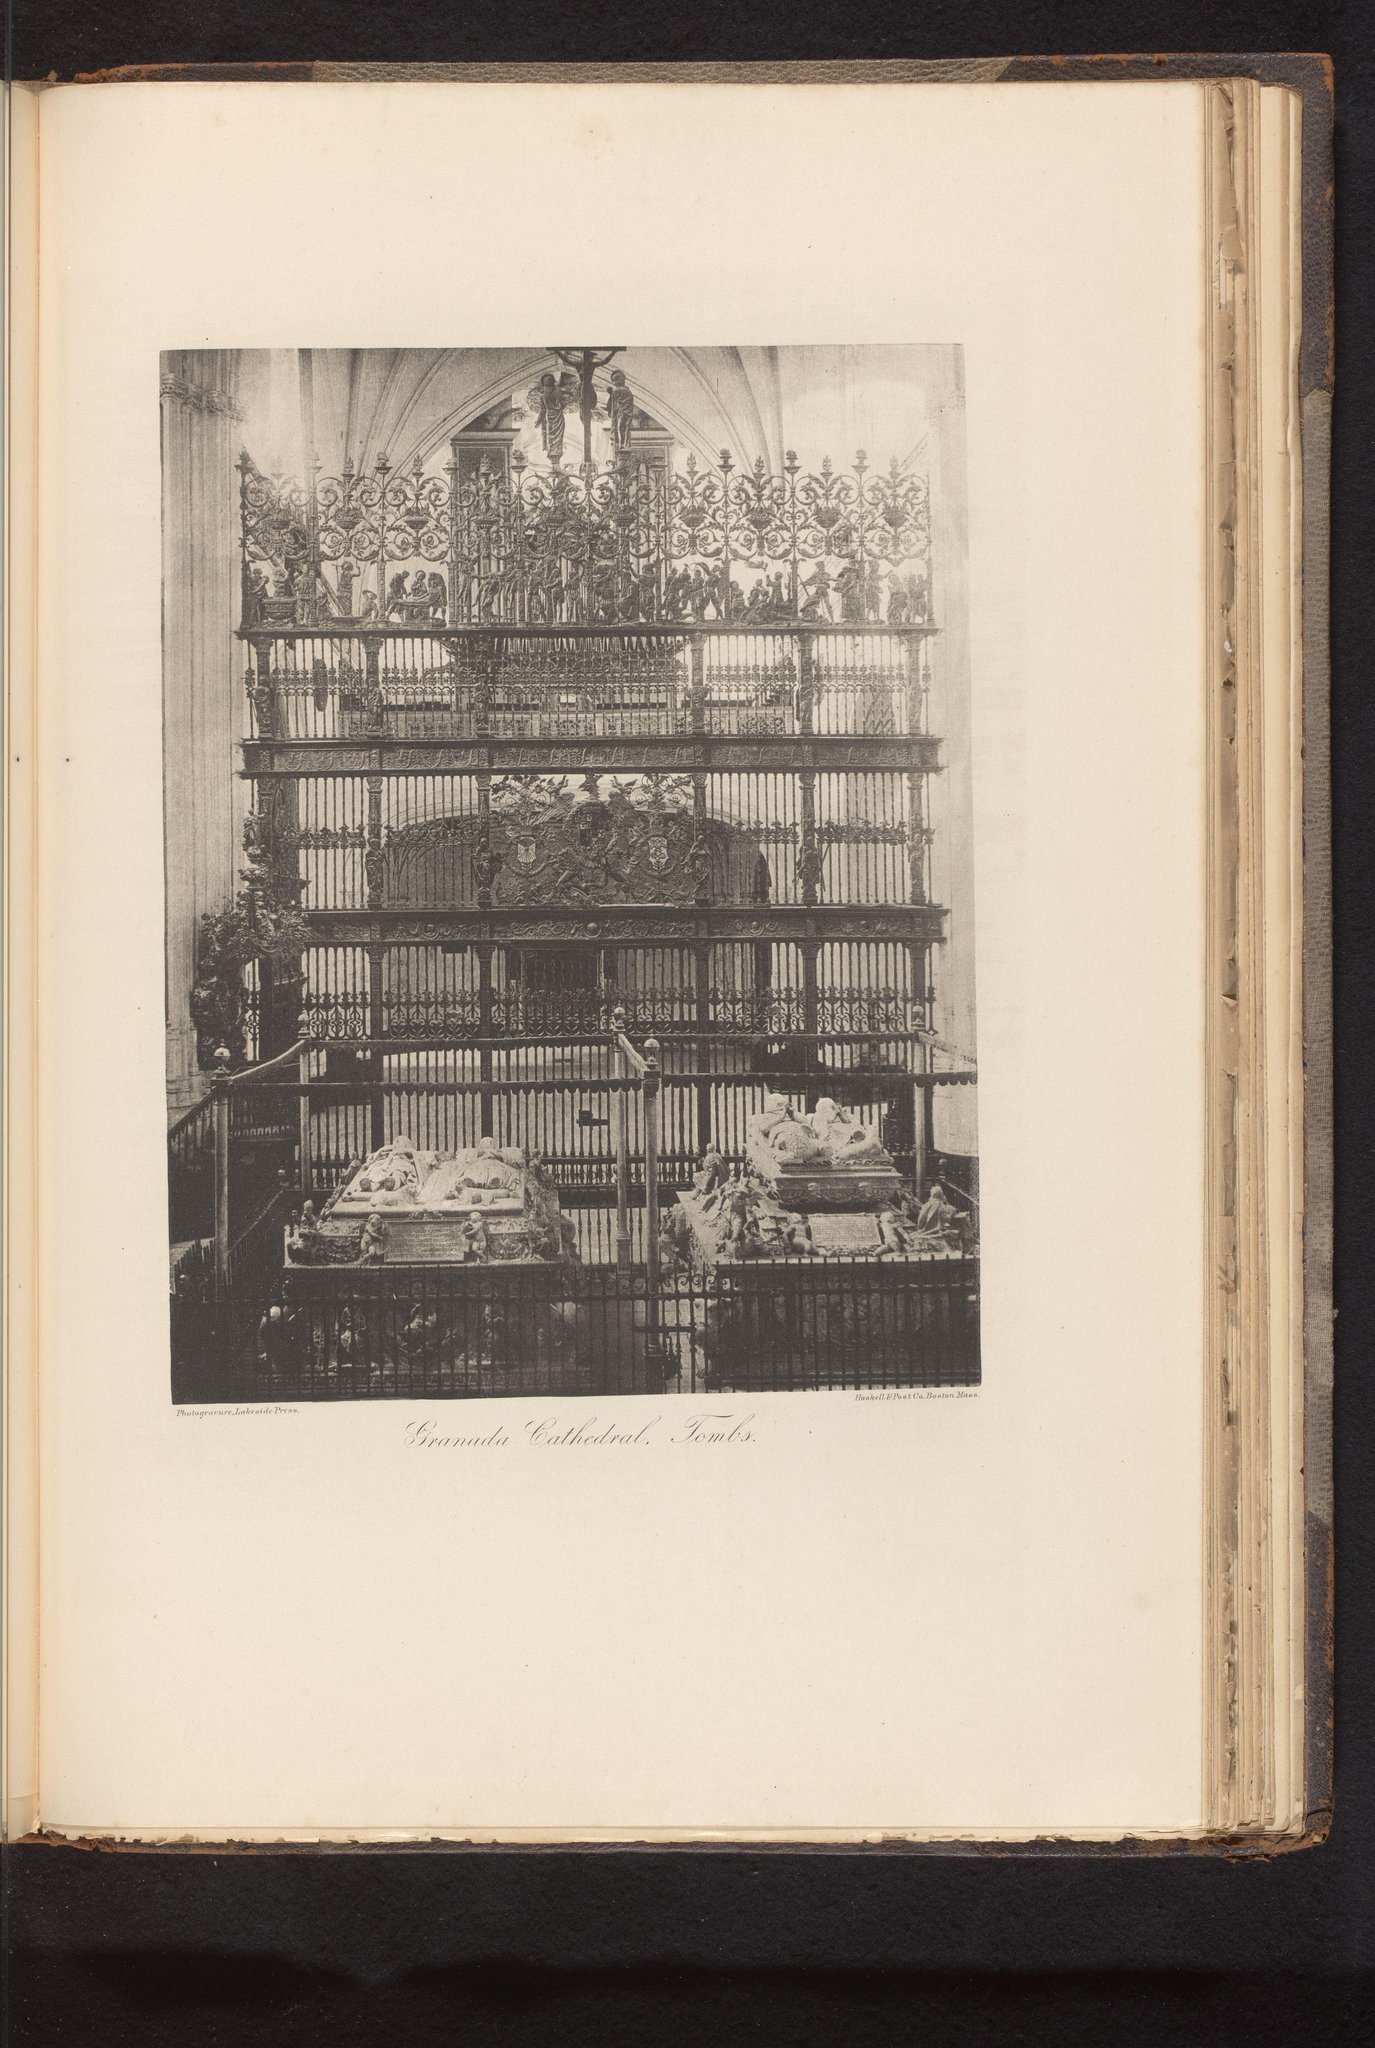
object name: page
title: Grafmonumenten van Isabella I en Ferdinand II de Katholieke, Johanna de Waanzinnige en Filips de Schone in de kathedraal van Granada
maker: Anonymous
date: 1881-1886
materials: paper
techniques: photograph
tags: bruges, filips de schone (hertog van bourgondië), grave-building, monumental tomb